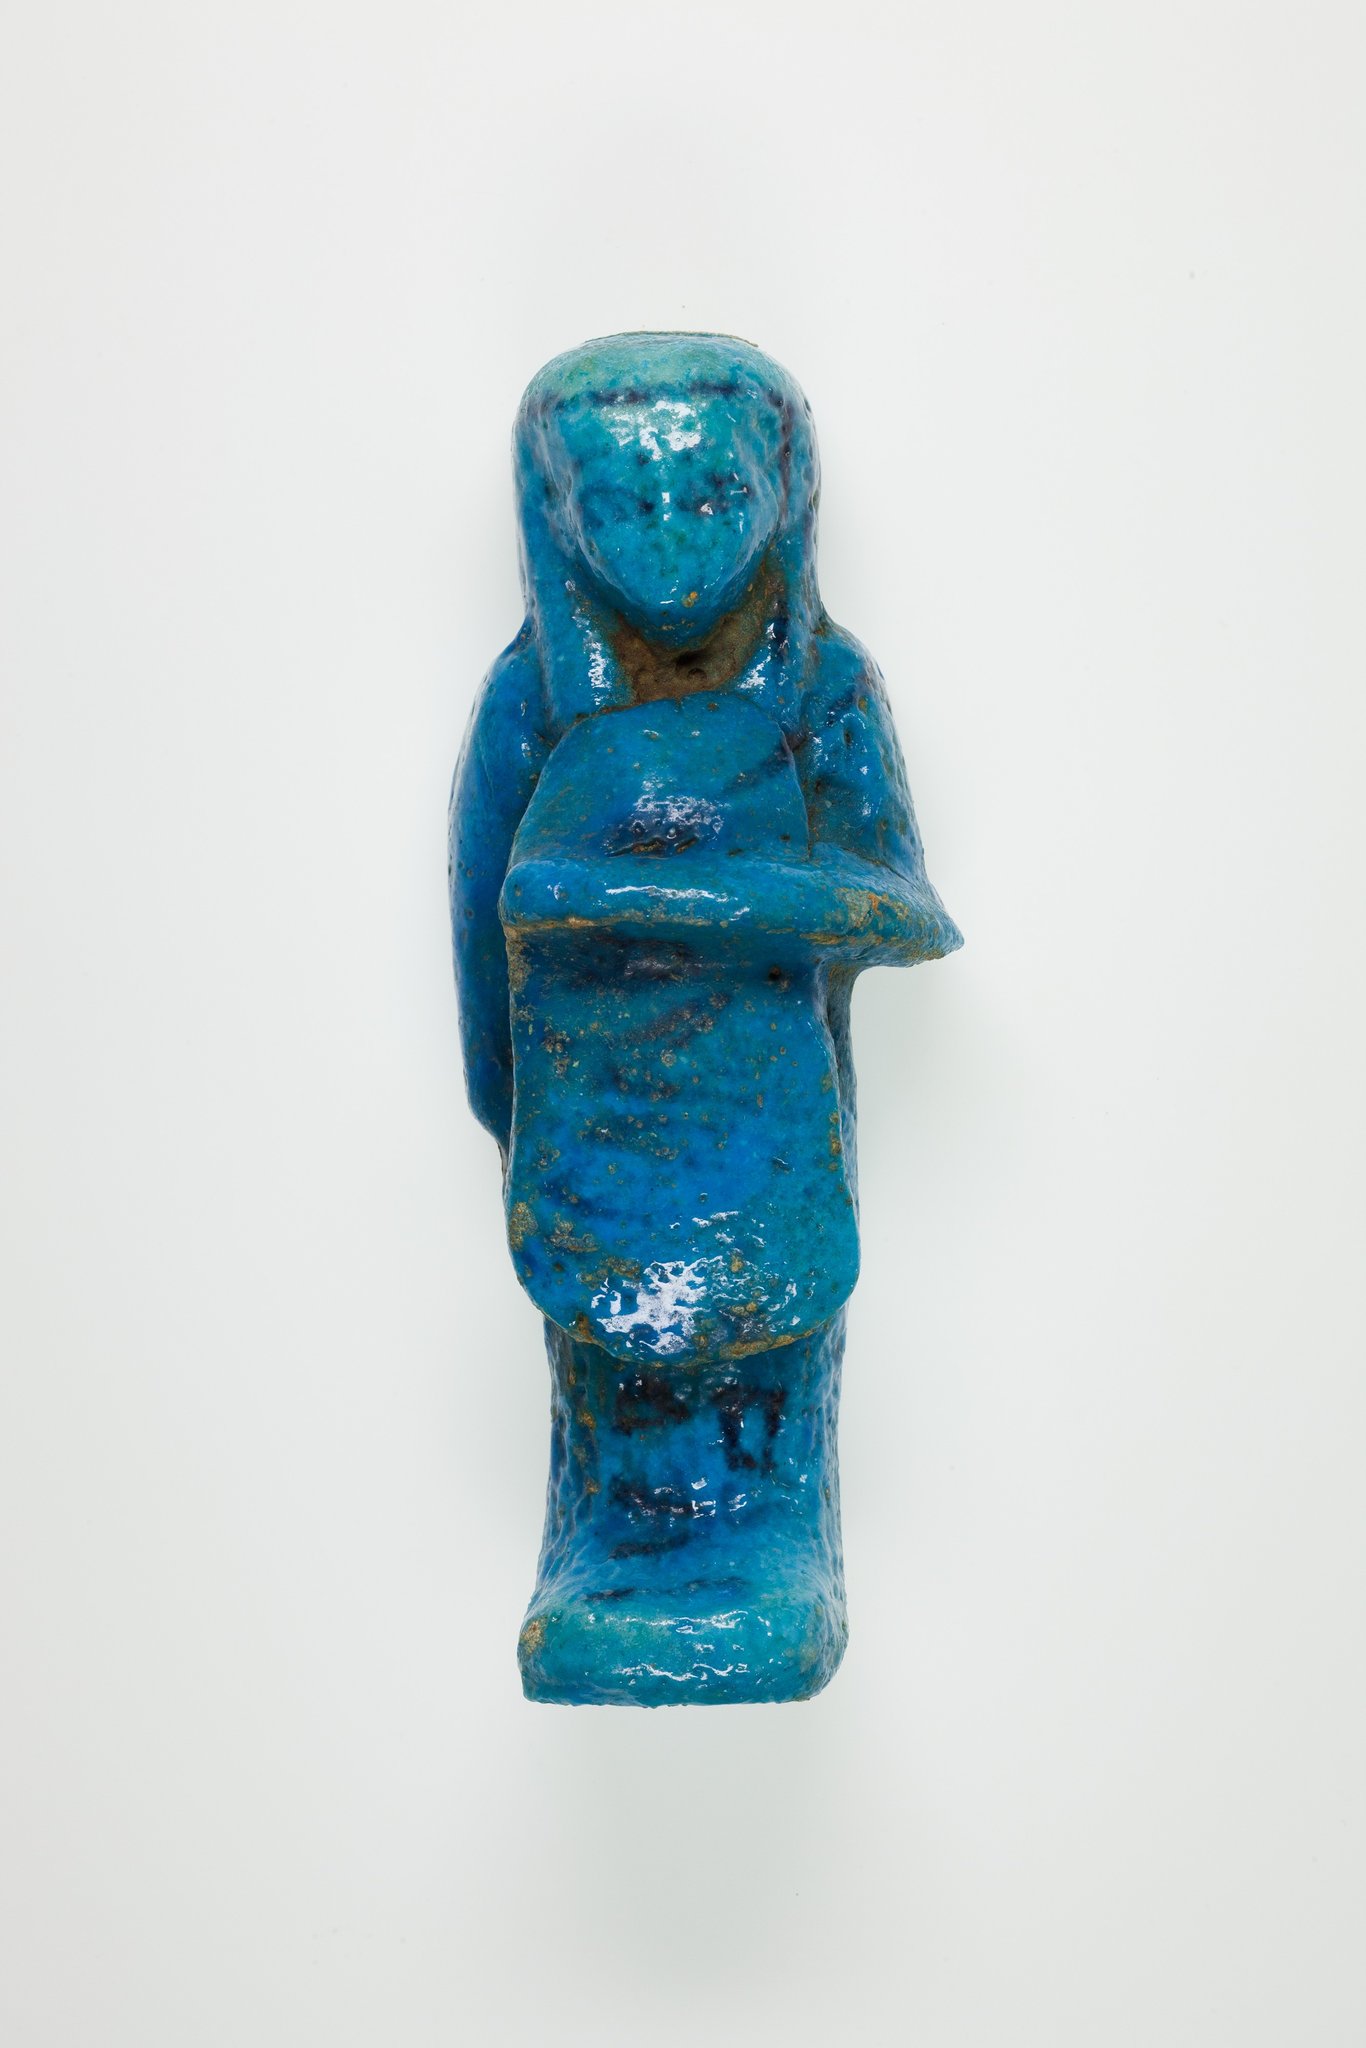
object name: overseer shabti, henettawy c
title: Overseer Shabti of Henettawy (C), Daughter of Isetemkheb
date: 990-970 BCE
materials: faience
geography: egypt